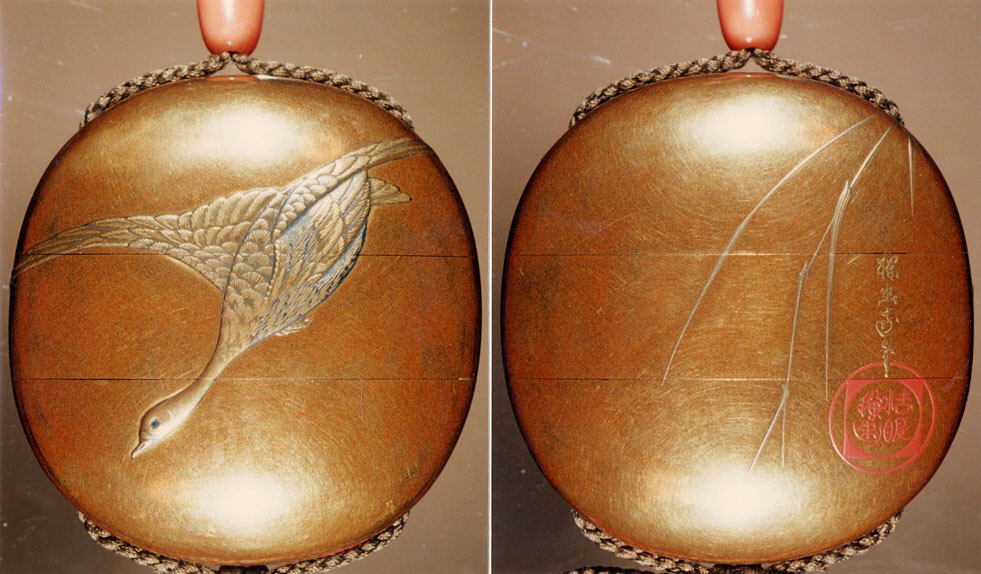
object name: inrō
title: Case (Inrō) with Design of Goose Flying Down (obverse); Inscription and Seal beside Reeds (reverse)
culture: japanese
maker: kano morinobu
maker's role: artist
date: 1801-1900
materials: gold, lacquer, silver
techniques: fundame, hiramakie, maki-e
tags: geese